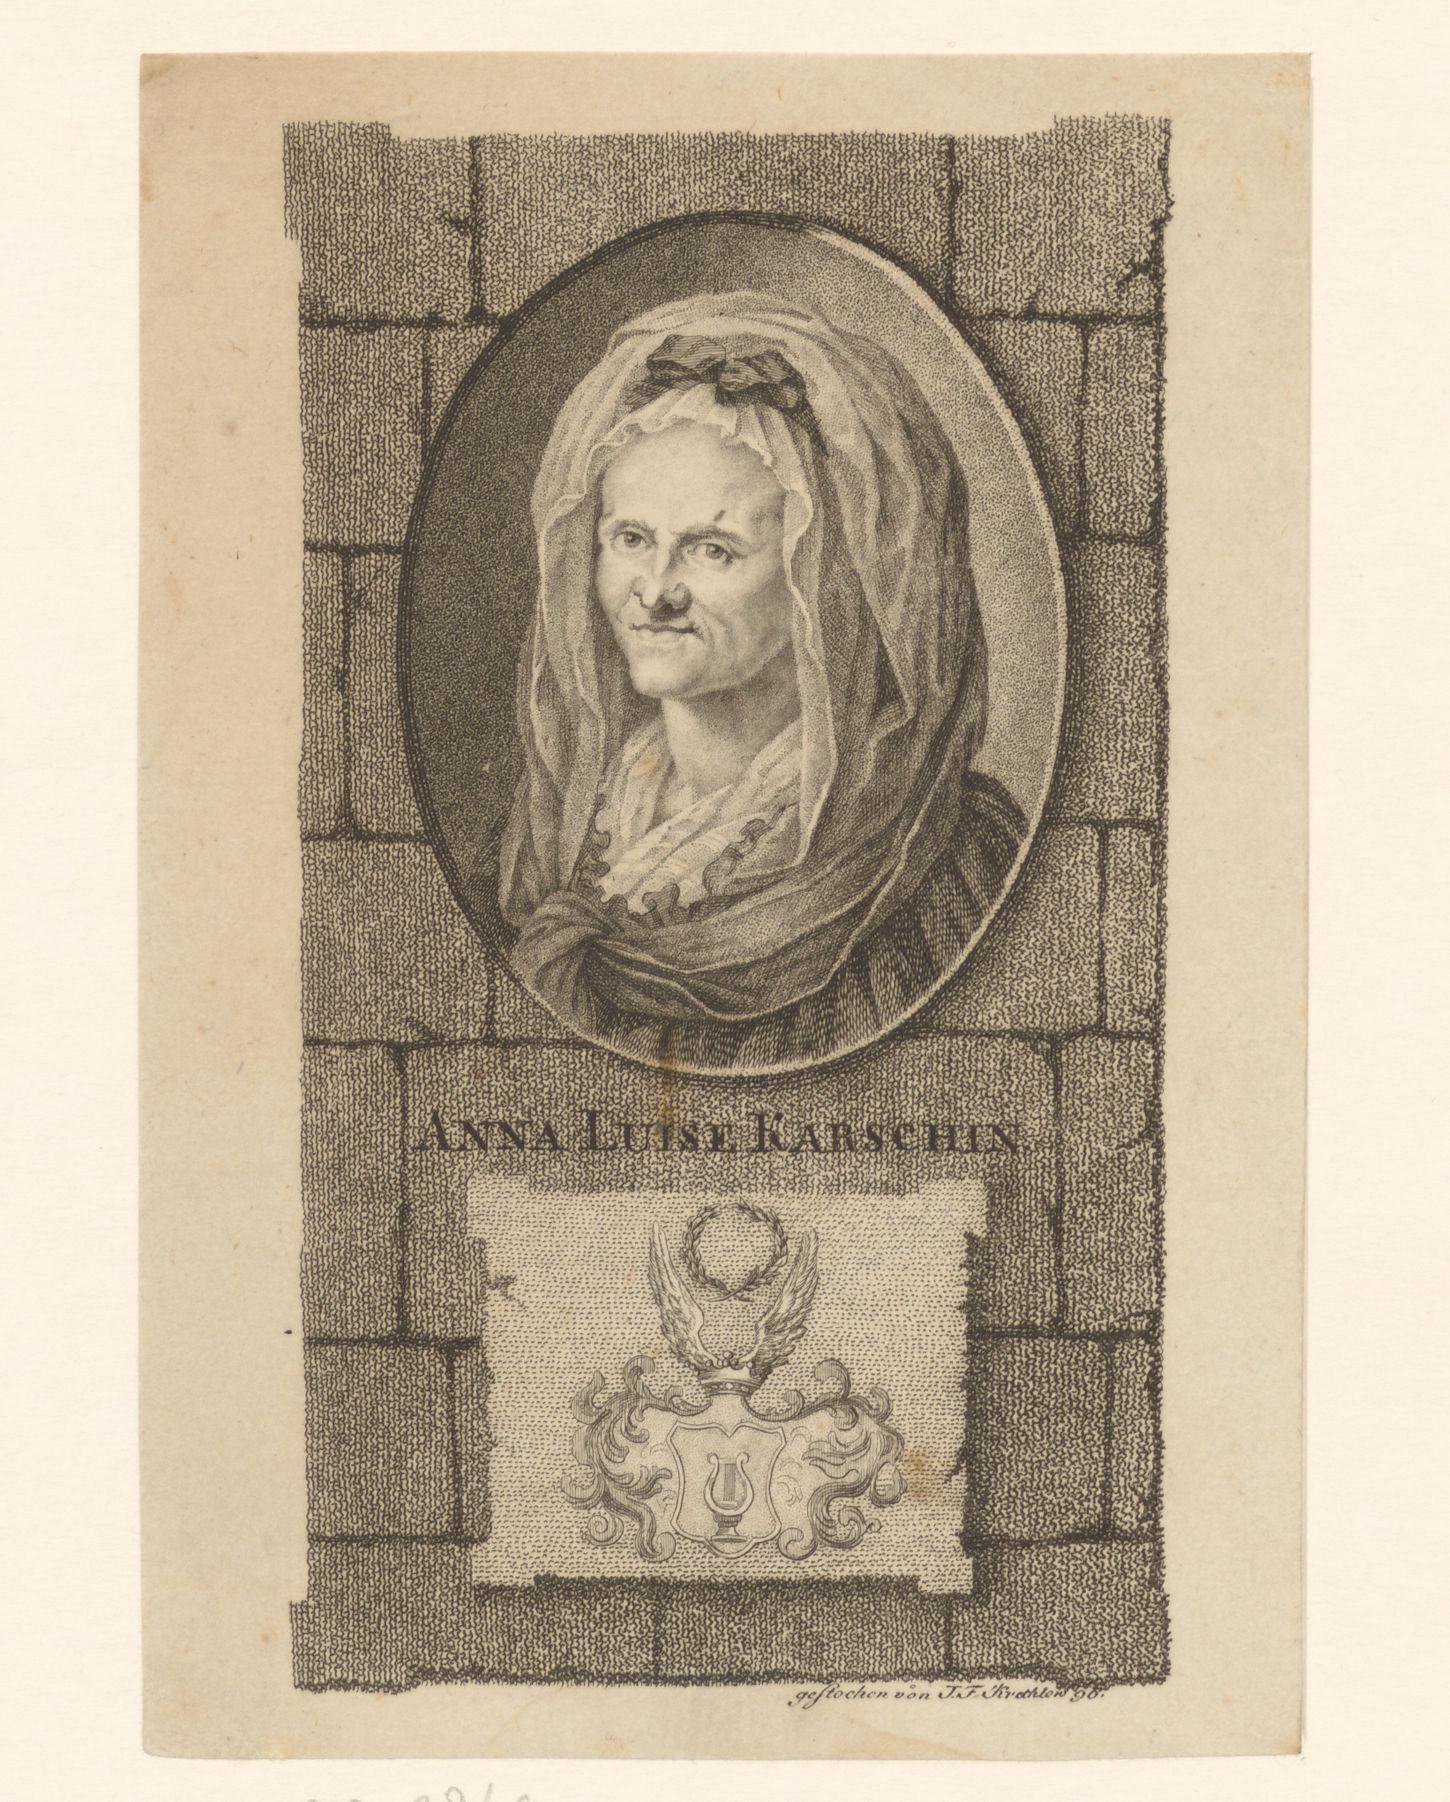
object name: print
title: Portret van Anne Luise Karsch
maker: johann ferdinand krethlow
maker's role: artist, draughtsman, print maker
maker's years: 1767-1842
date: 1795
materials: paper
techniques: stippling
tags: berlin, historical persons, writer, poet, author, ornament derived from architectural details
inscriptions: collector's mark: Lugt 2228